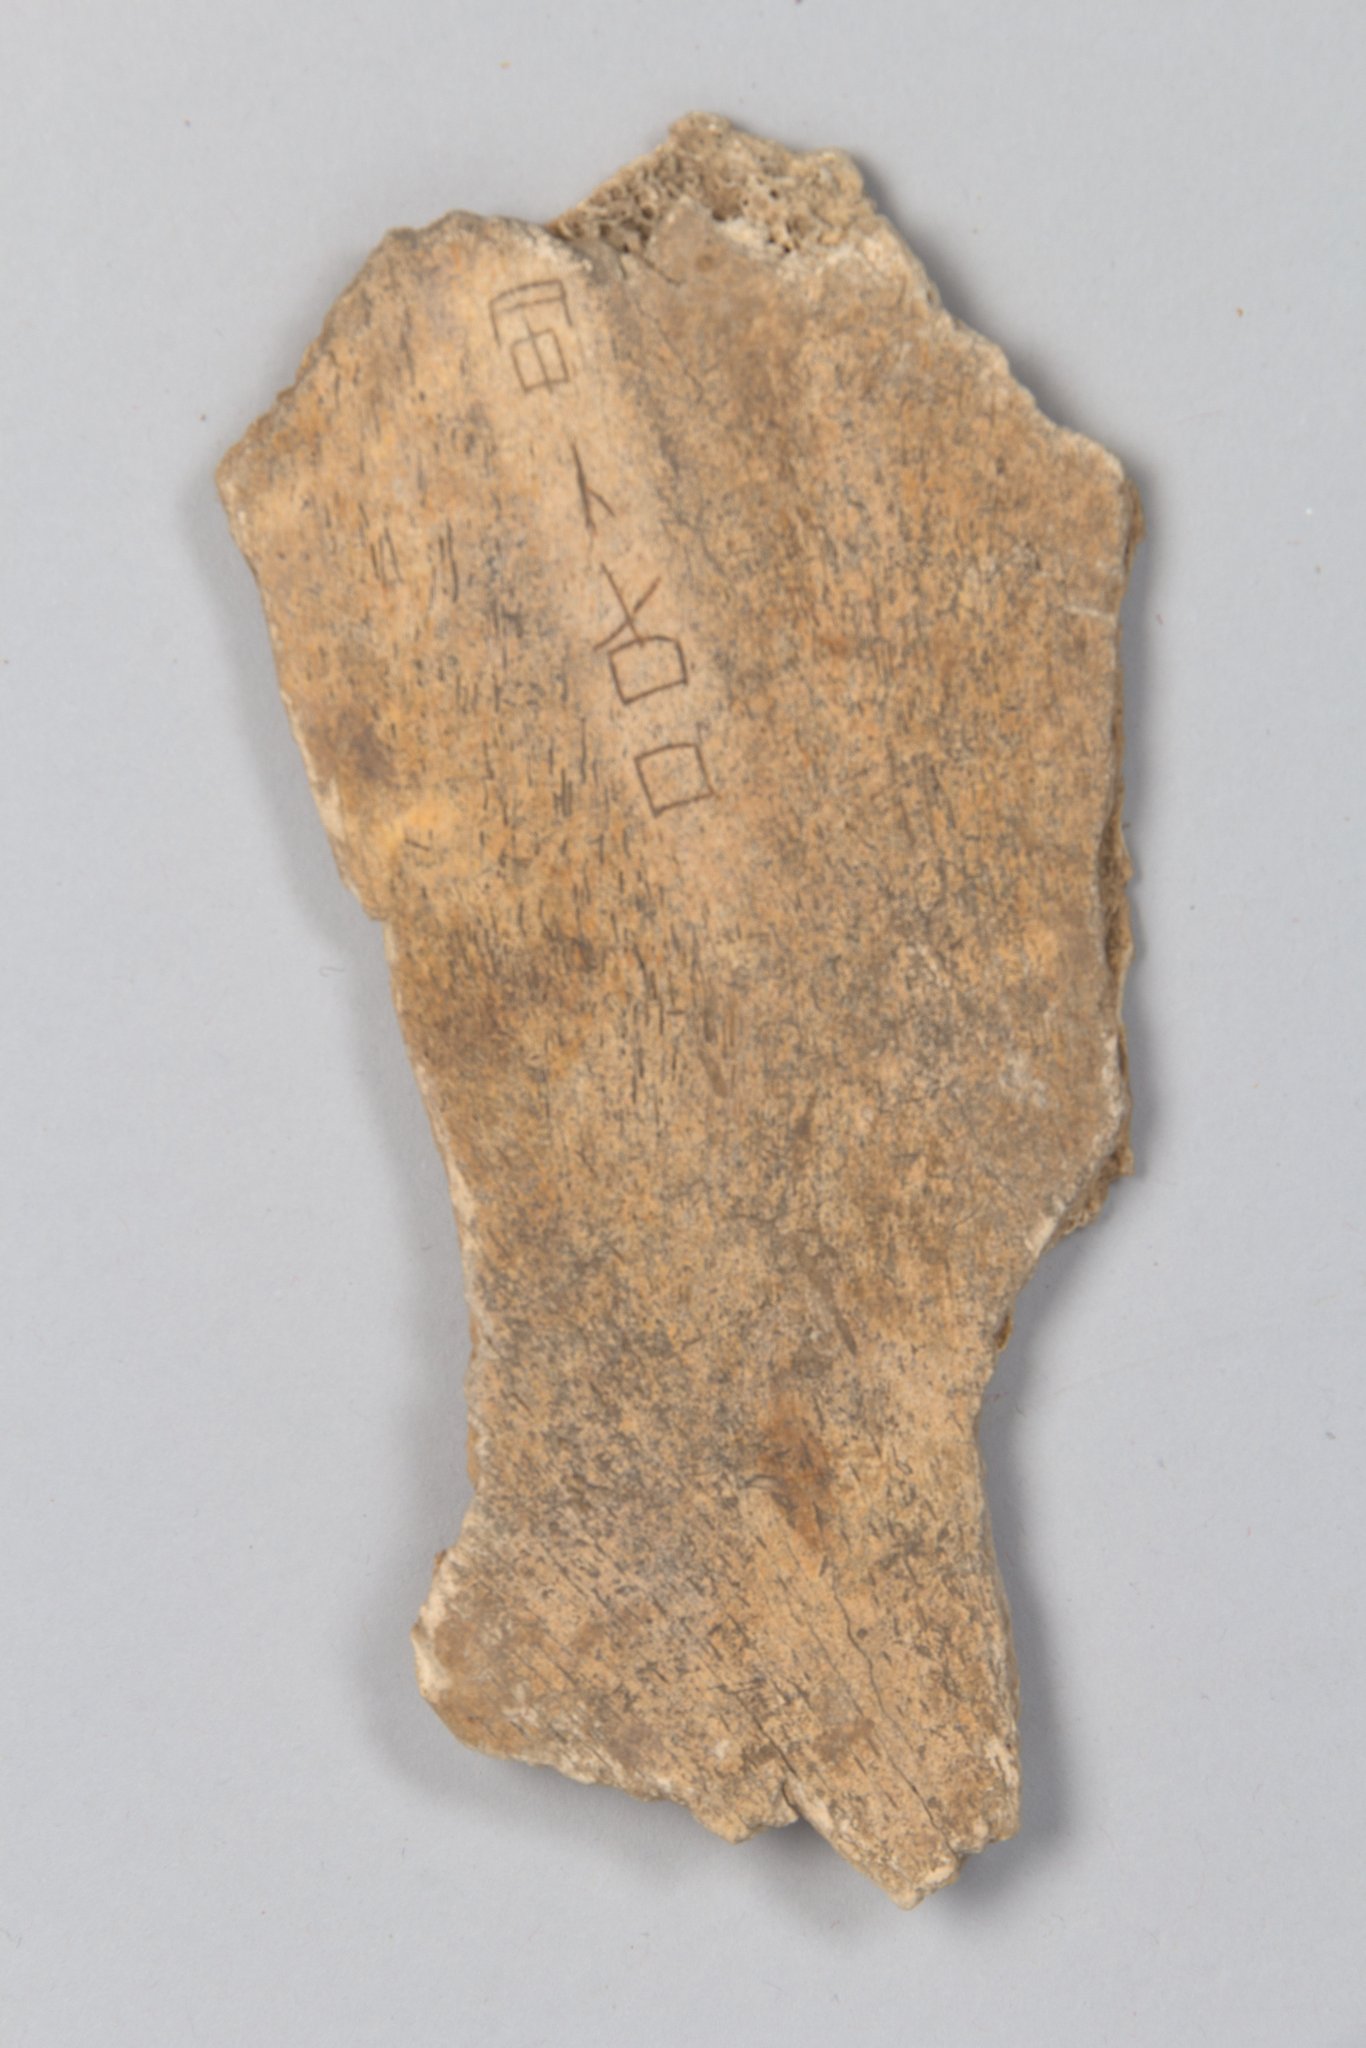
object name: oracle bone fragment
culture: chinese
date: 1610-1036 BCE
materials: bone